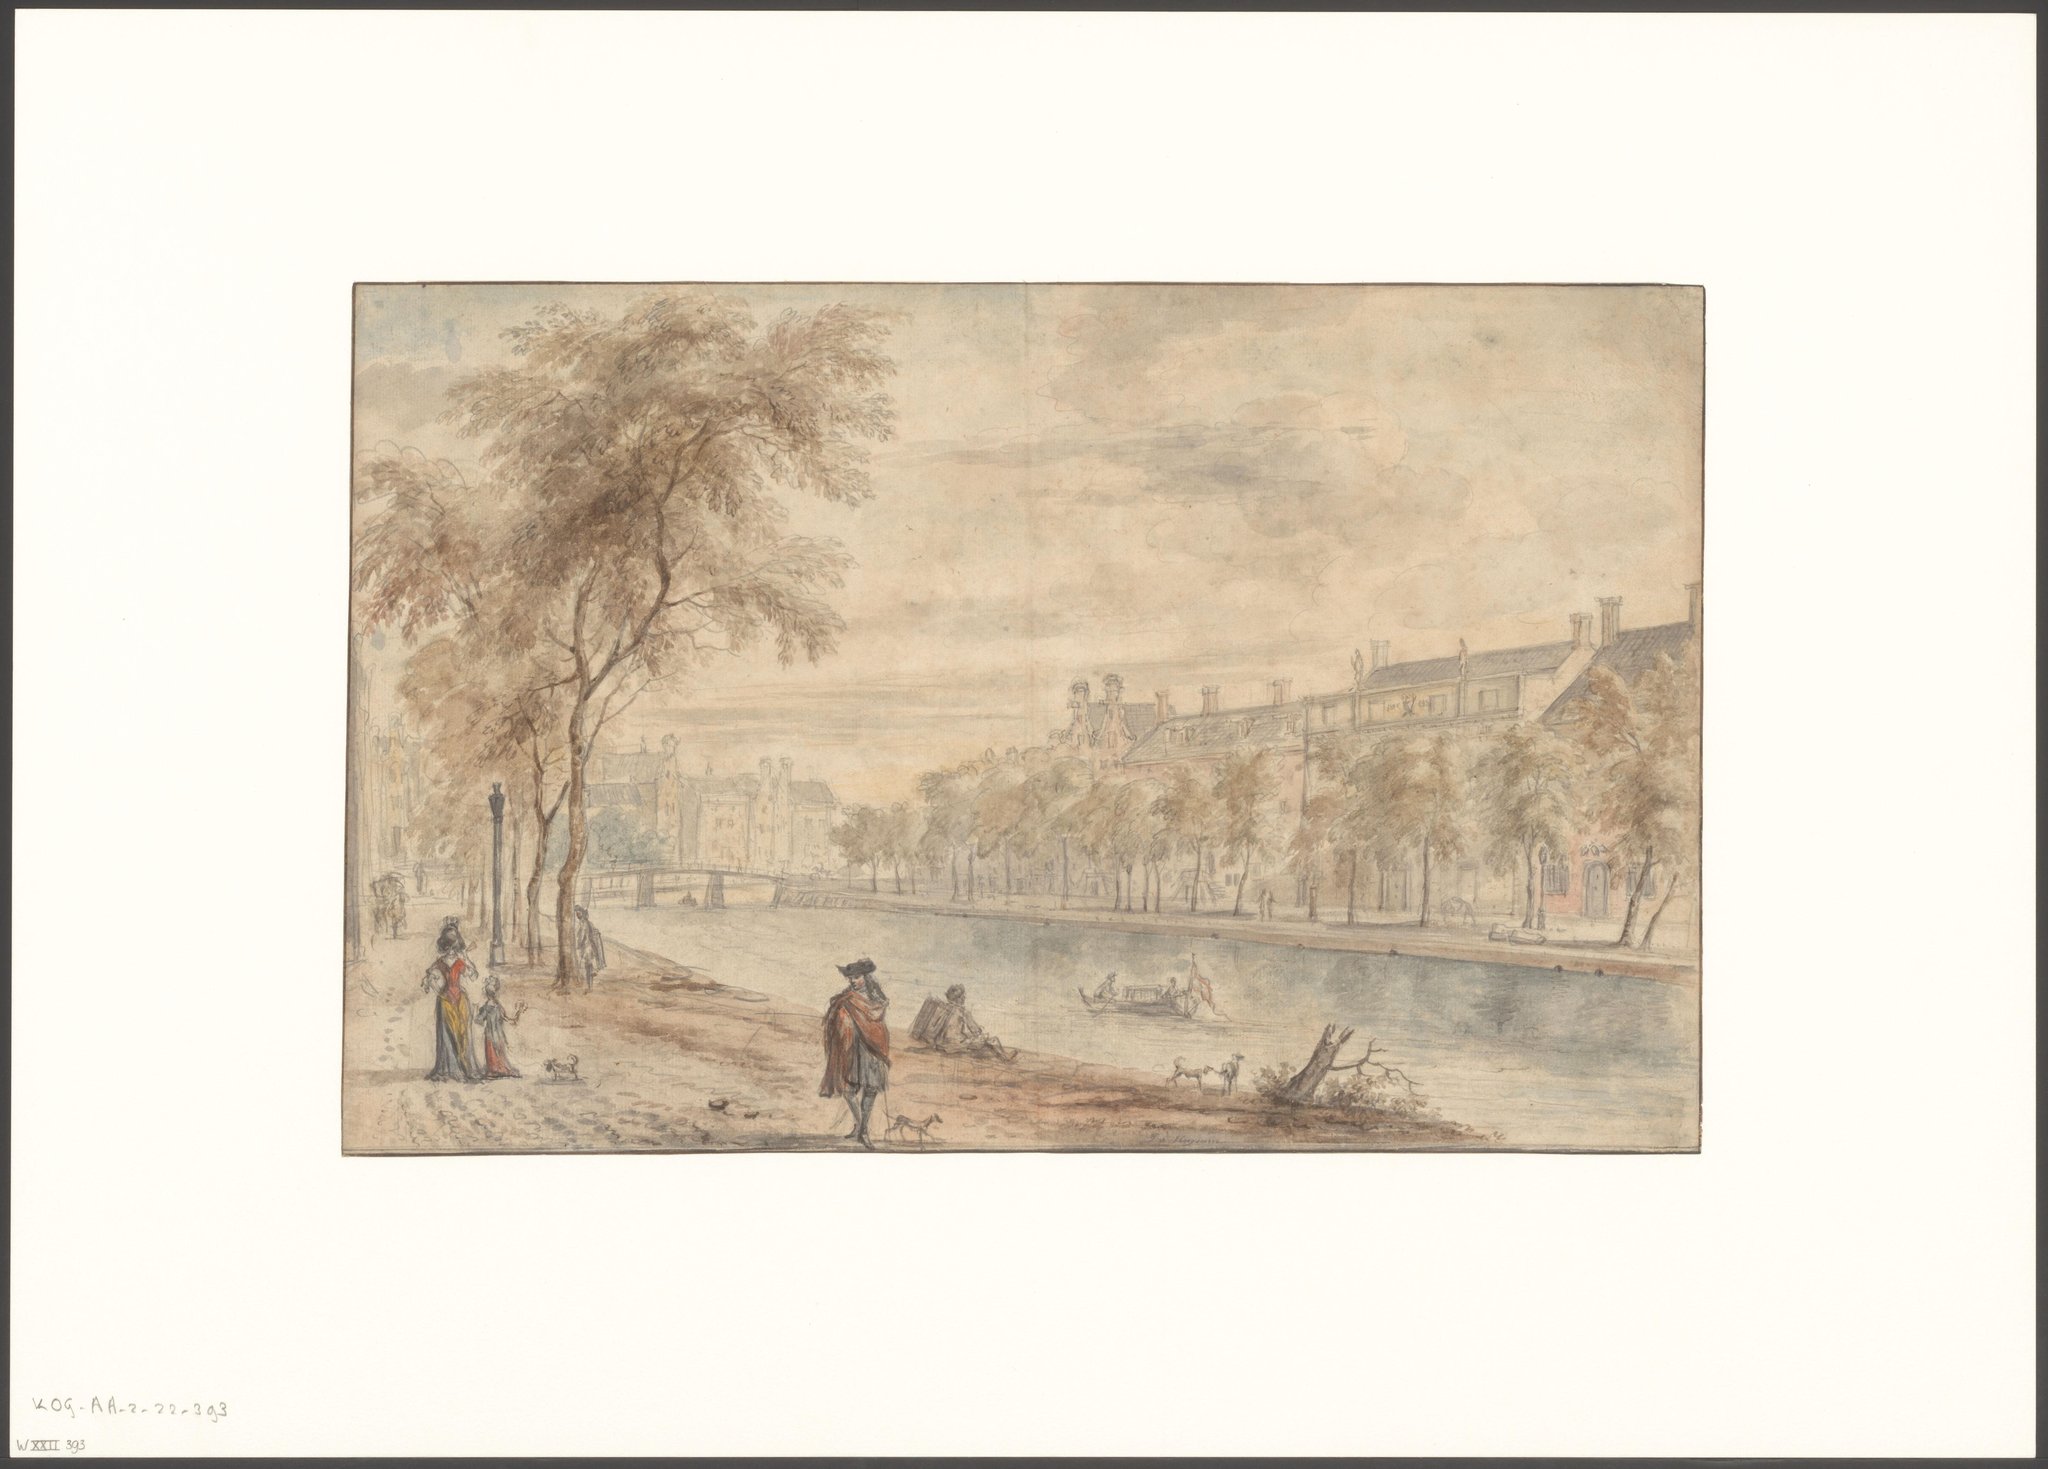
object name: drawing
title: Gezicht op de Keizersgracht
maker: jan van huysum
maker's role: draughtsman, painter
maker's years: 1682-1749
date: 1692-1749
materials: paper, pencil, watercolor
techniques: brush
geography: amsterdam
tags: city-view in general; 'veduta', canal, bridge in city across river, canal, etc.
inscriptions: signature: ‘J v Huysum’, collector's mark: Lugt 800a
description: Tekening binnen de Atlas Van Eck ingedeeld op wijknummer 22.